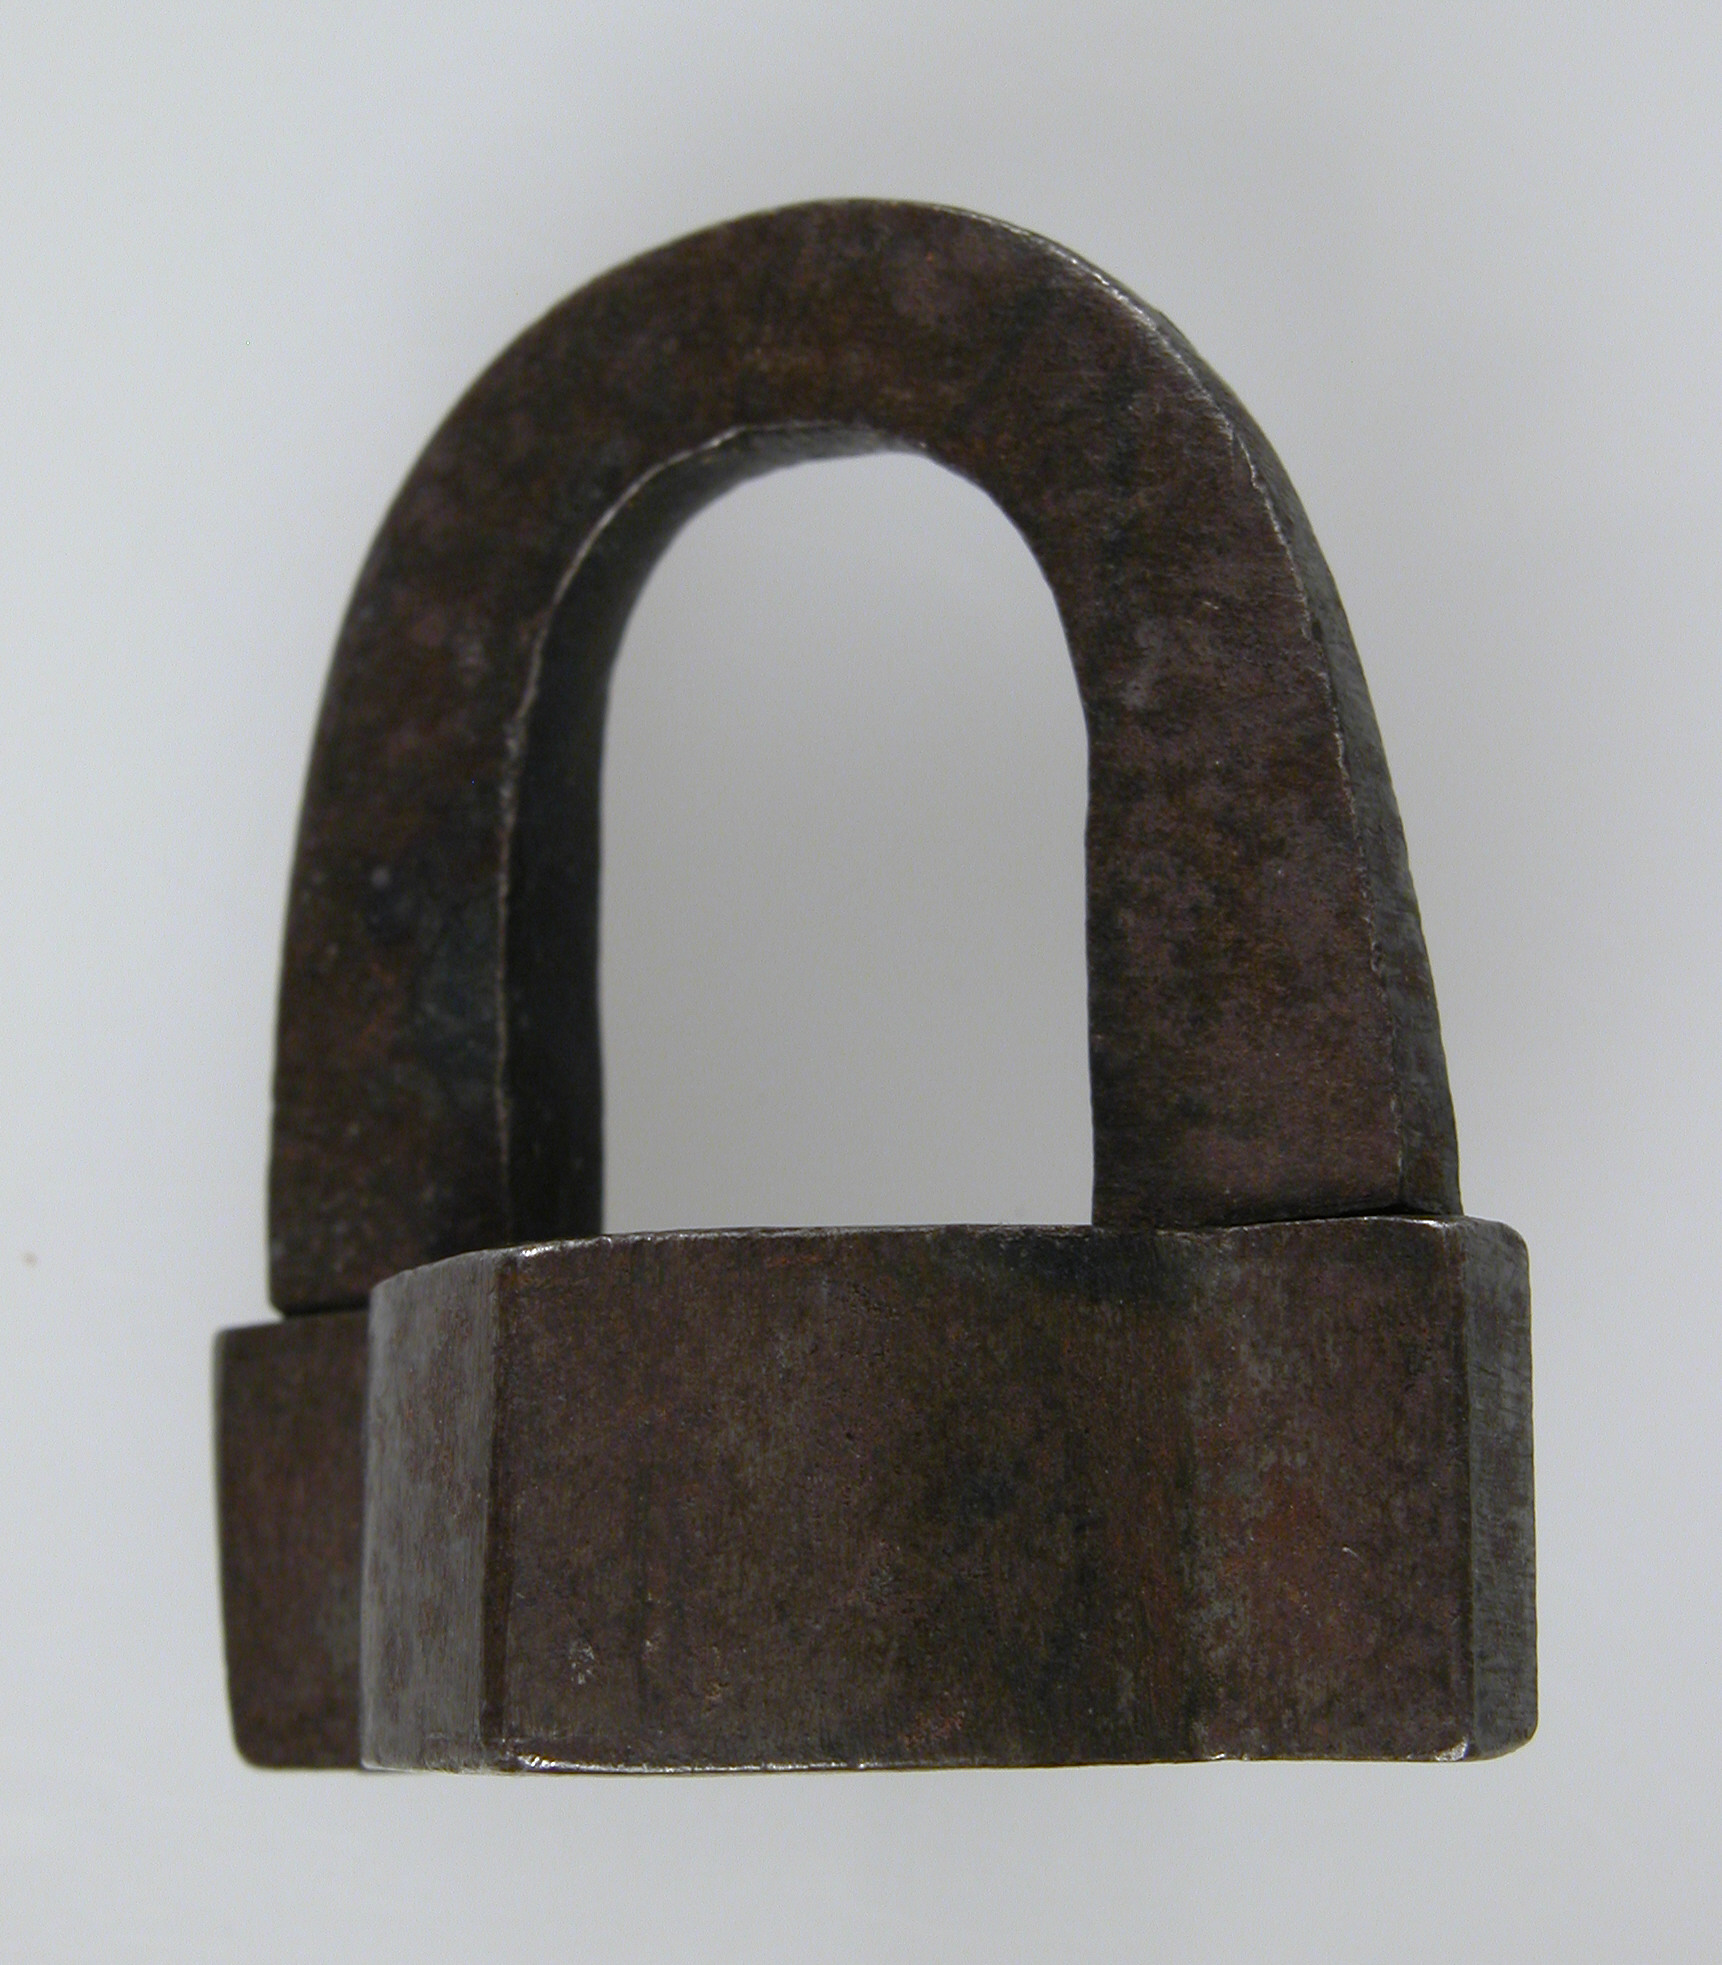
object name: padlock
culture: french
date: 1501-1600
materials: iron